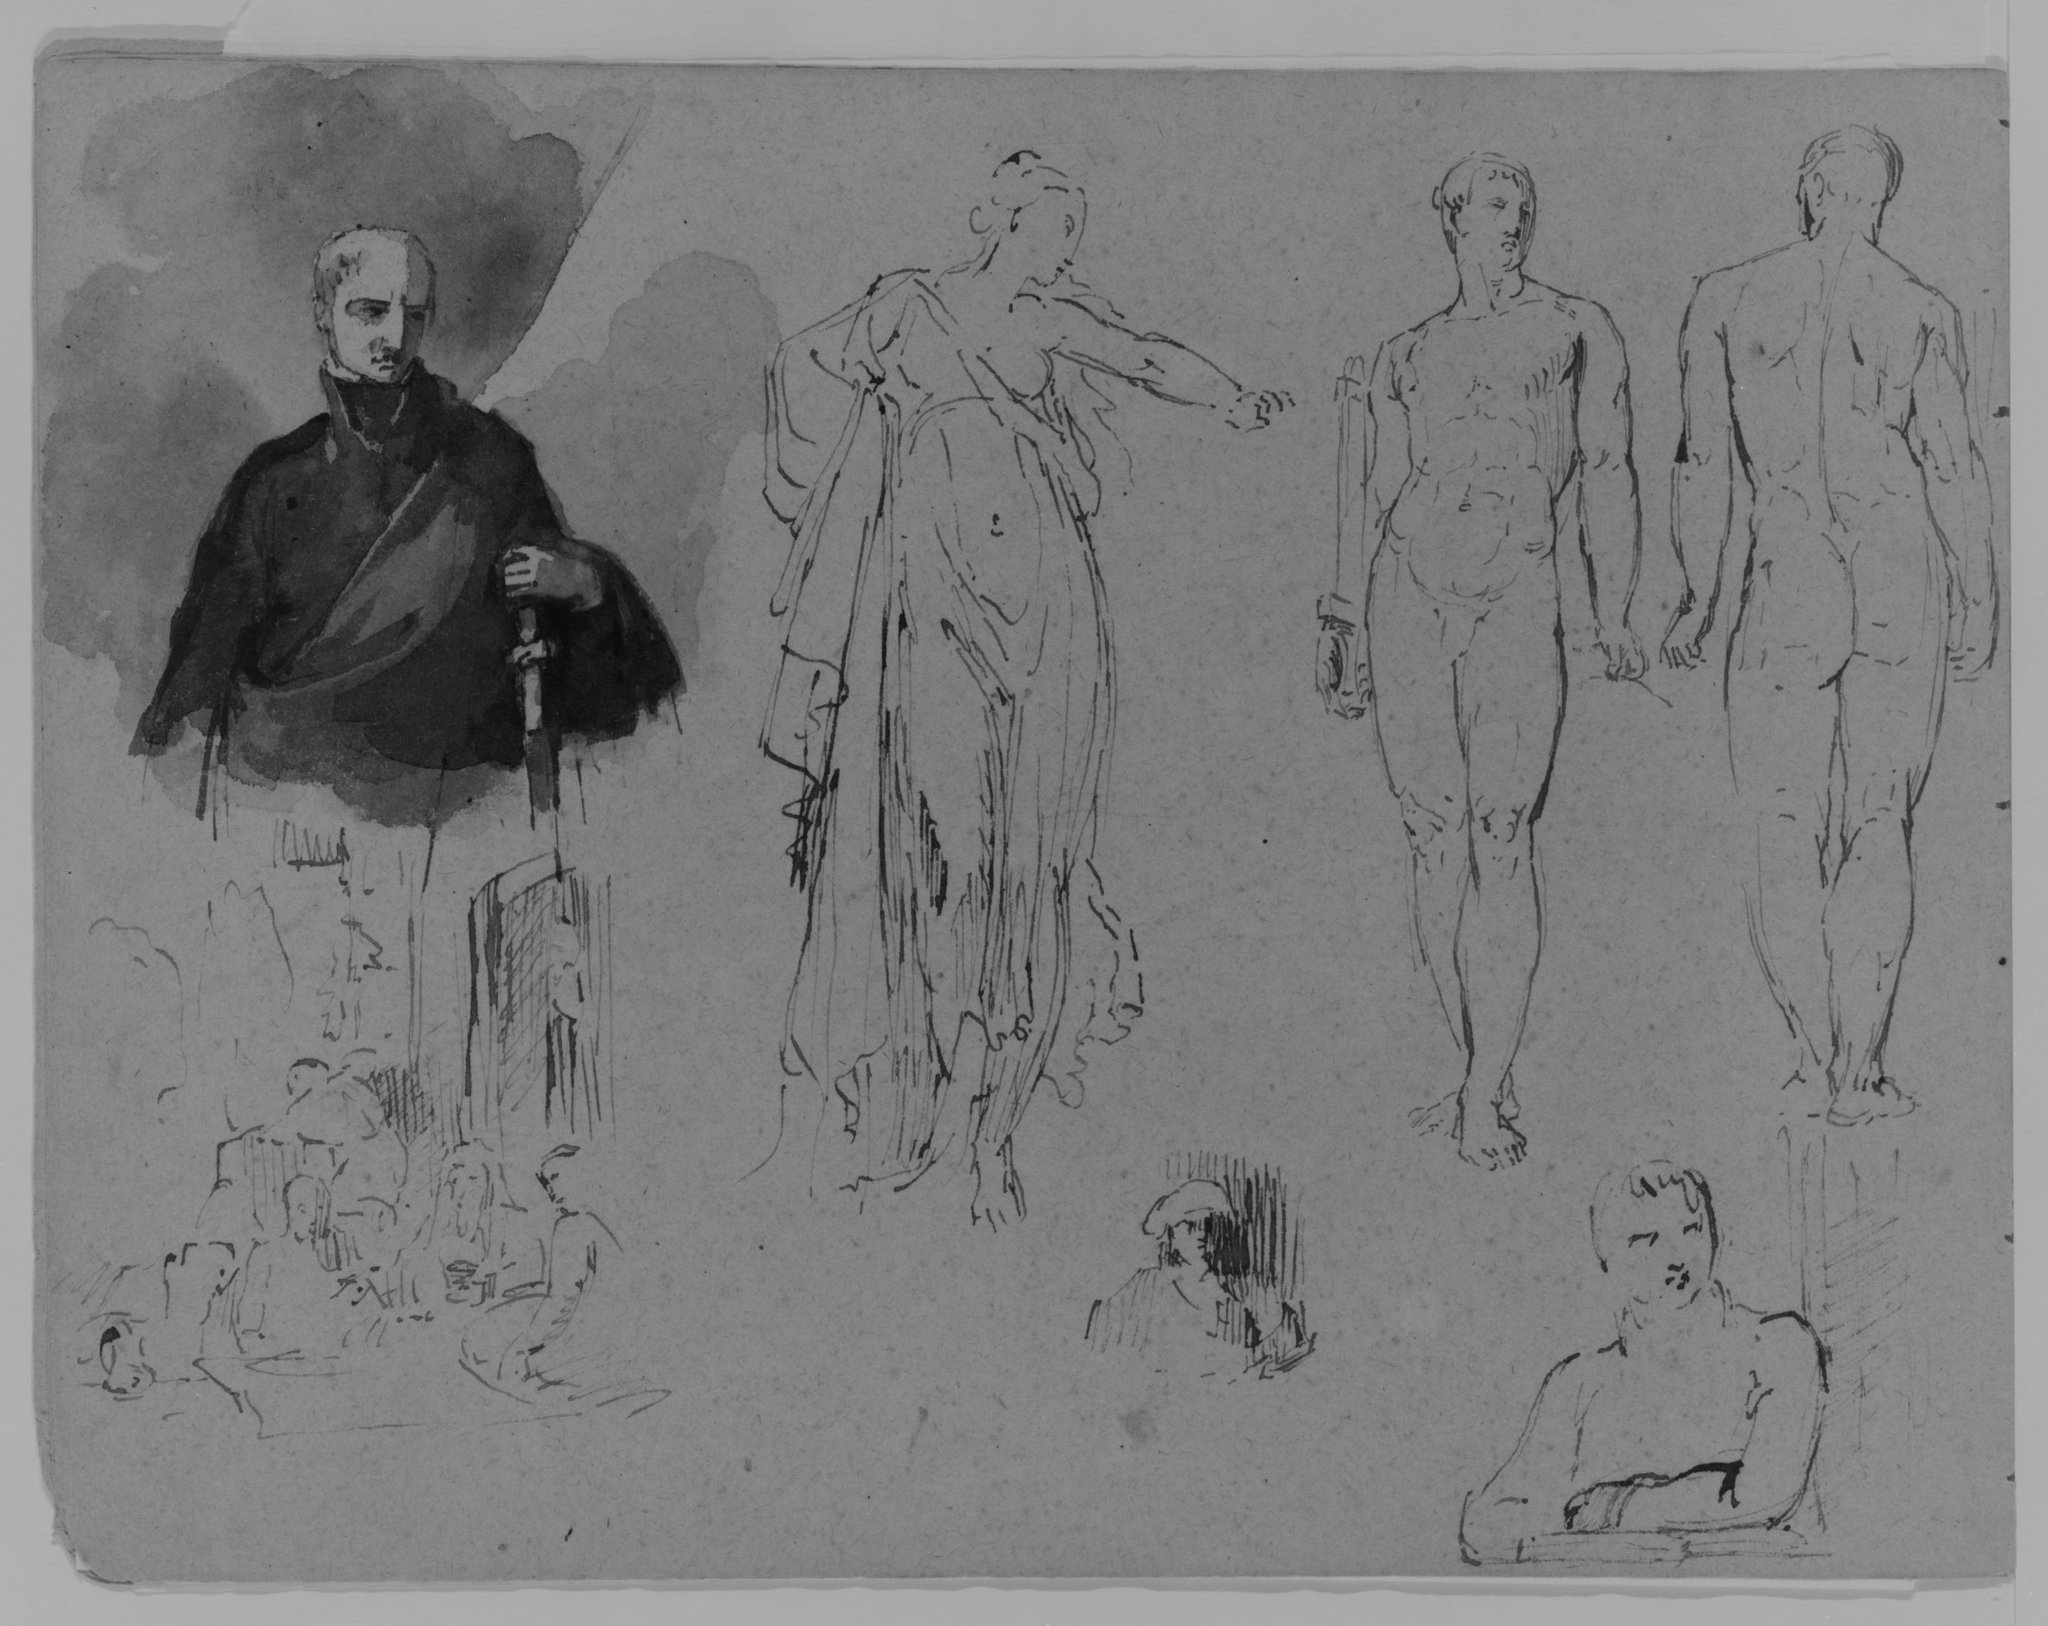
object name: drawing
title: (From Sketchbook)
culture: american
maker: thomas sully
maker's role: artist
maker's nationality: american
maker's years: 1783-1872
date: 1810-1820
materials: ink, paper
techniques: wash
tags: men,male nudes,portraits,women